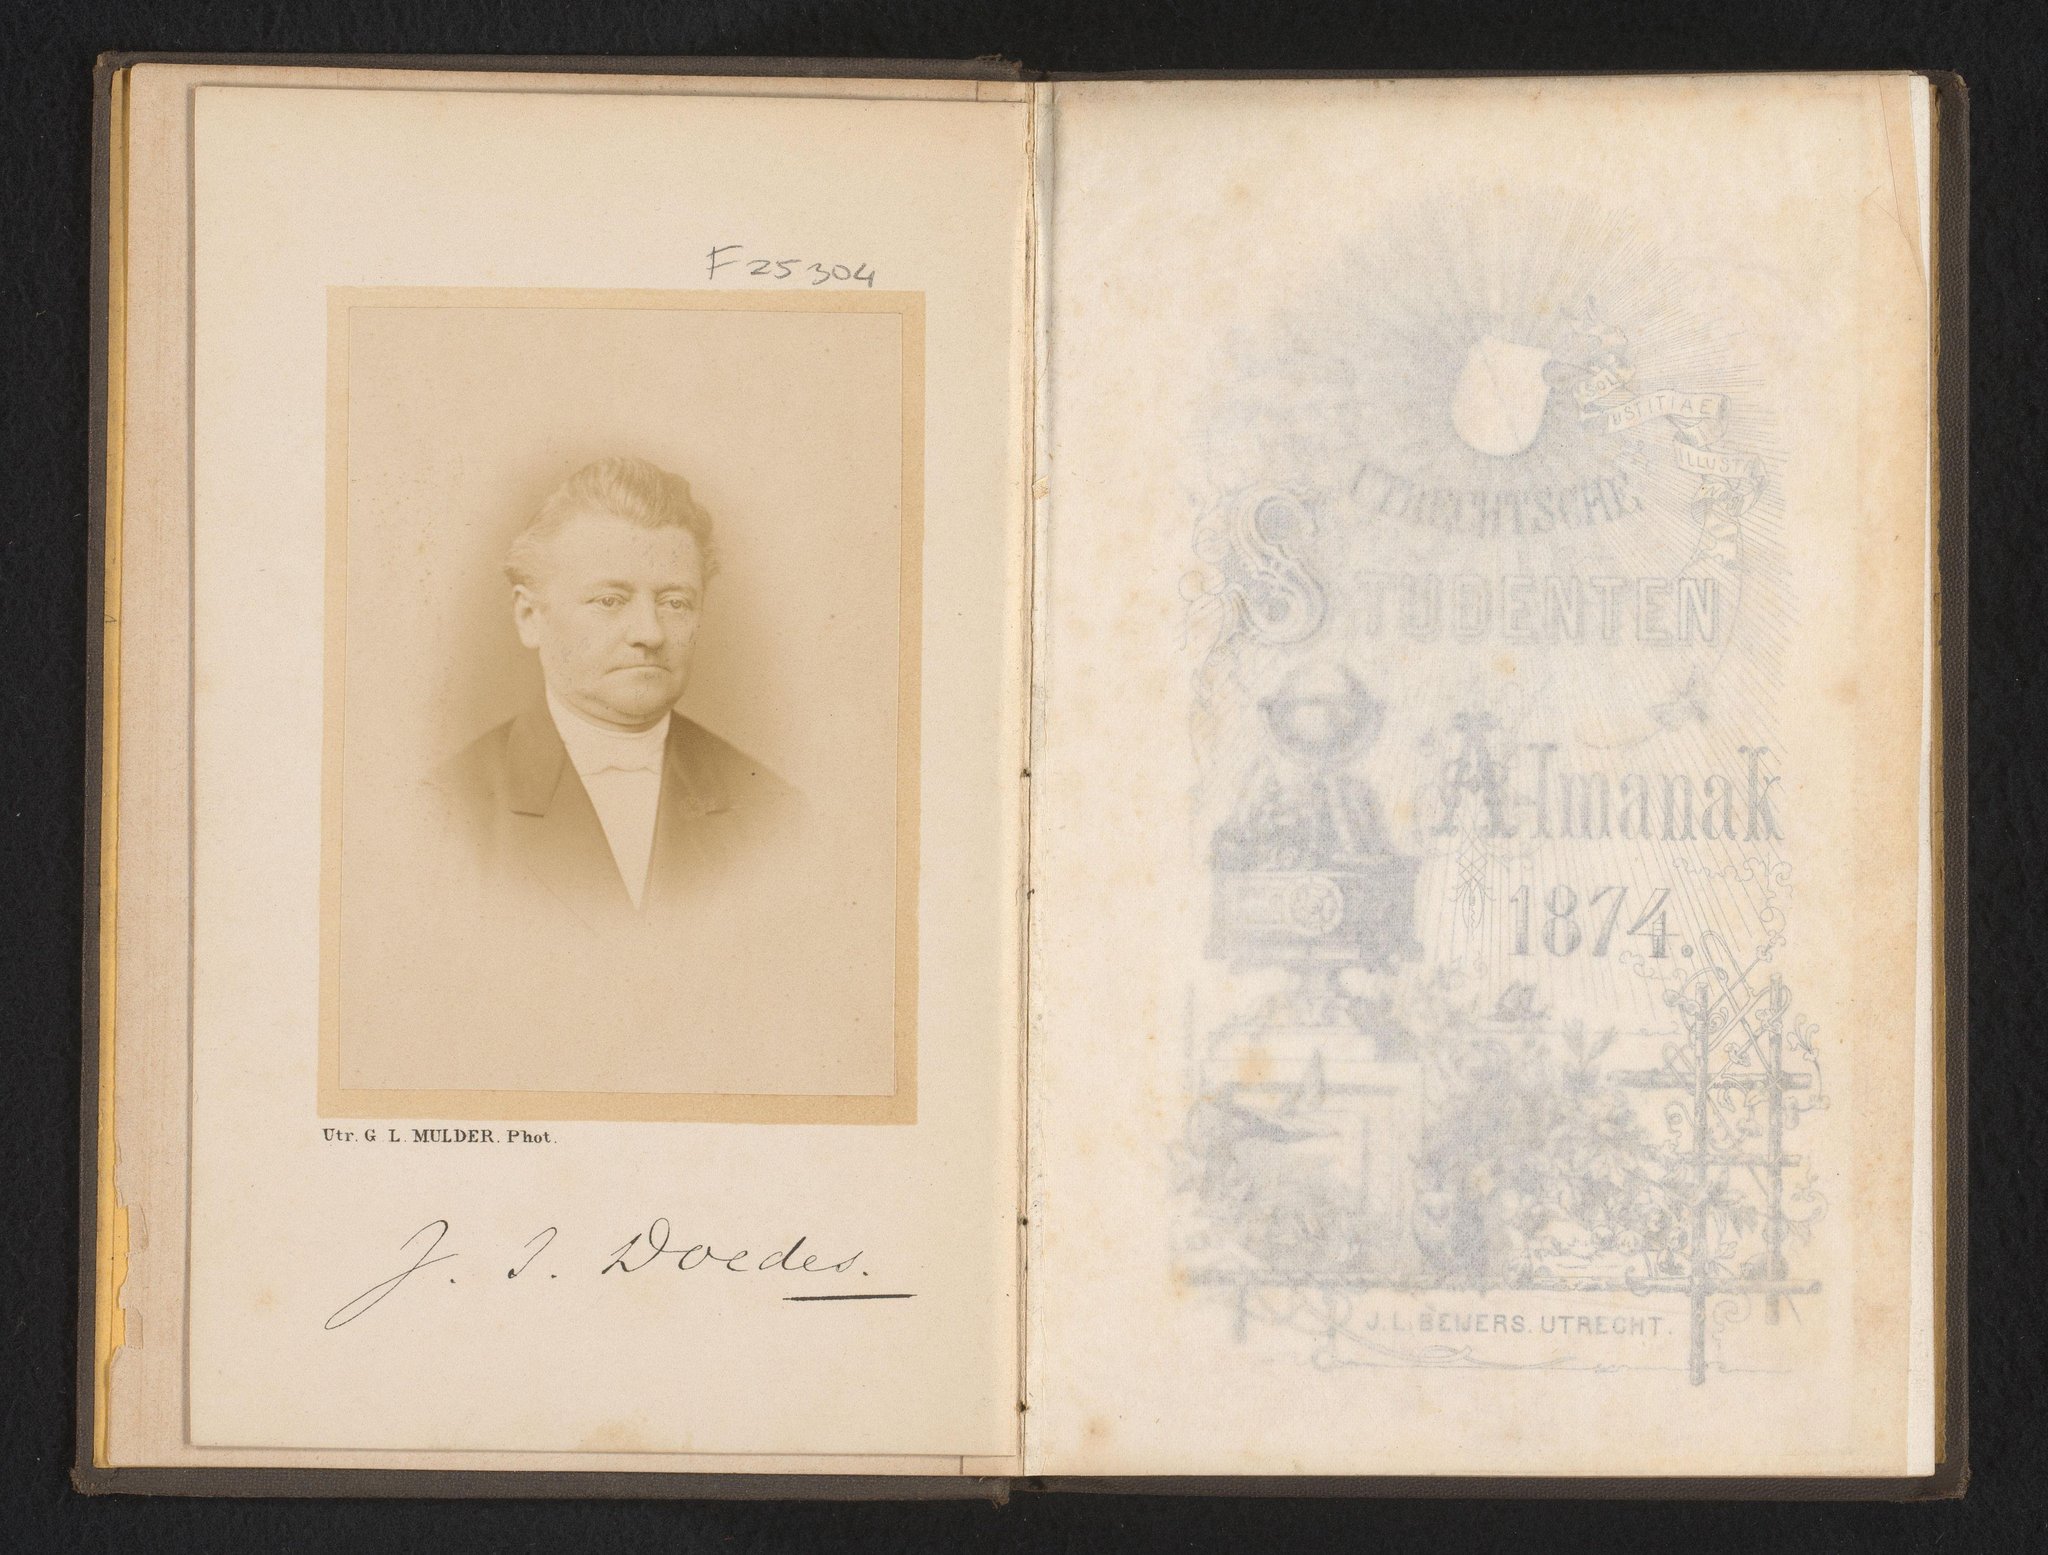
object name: photograph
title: Portret van J.I. Doedes, hoogleraar godgeleerdheid en rector magnificus van de Universiteit Utrecht 1873-1874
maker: george lodewijk mulder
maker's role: fotograaf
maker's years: 1841-1920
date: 1873-1874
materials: cardboard, paper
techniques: albumen print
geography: utrecht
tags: utrecht, historical persons, professor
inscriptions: signature: ‘J.I. Doedes’